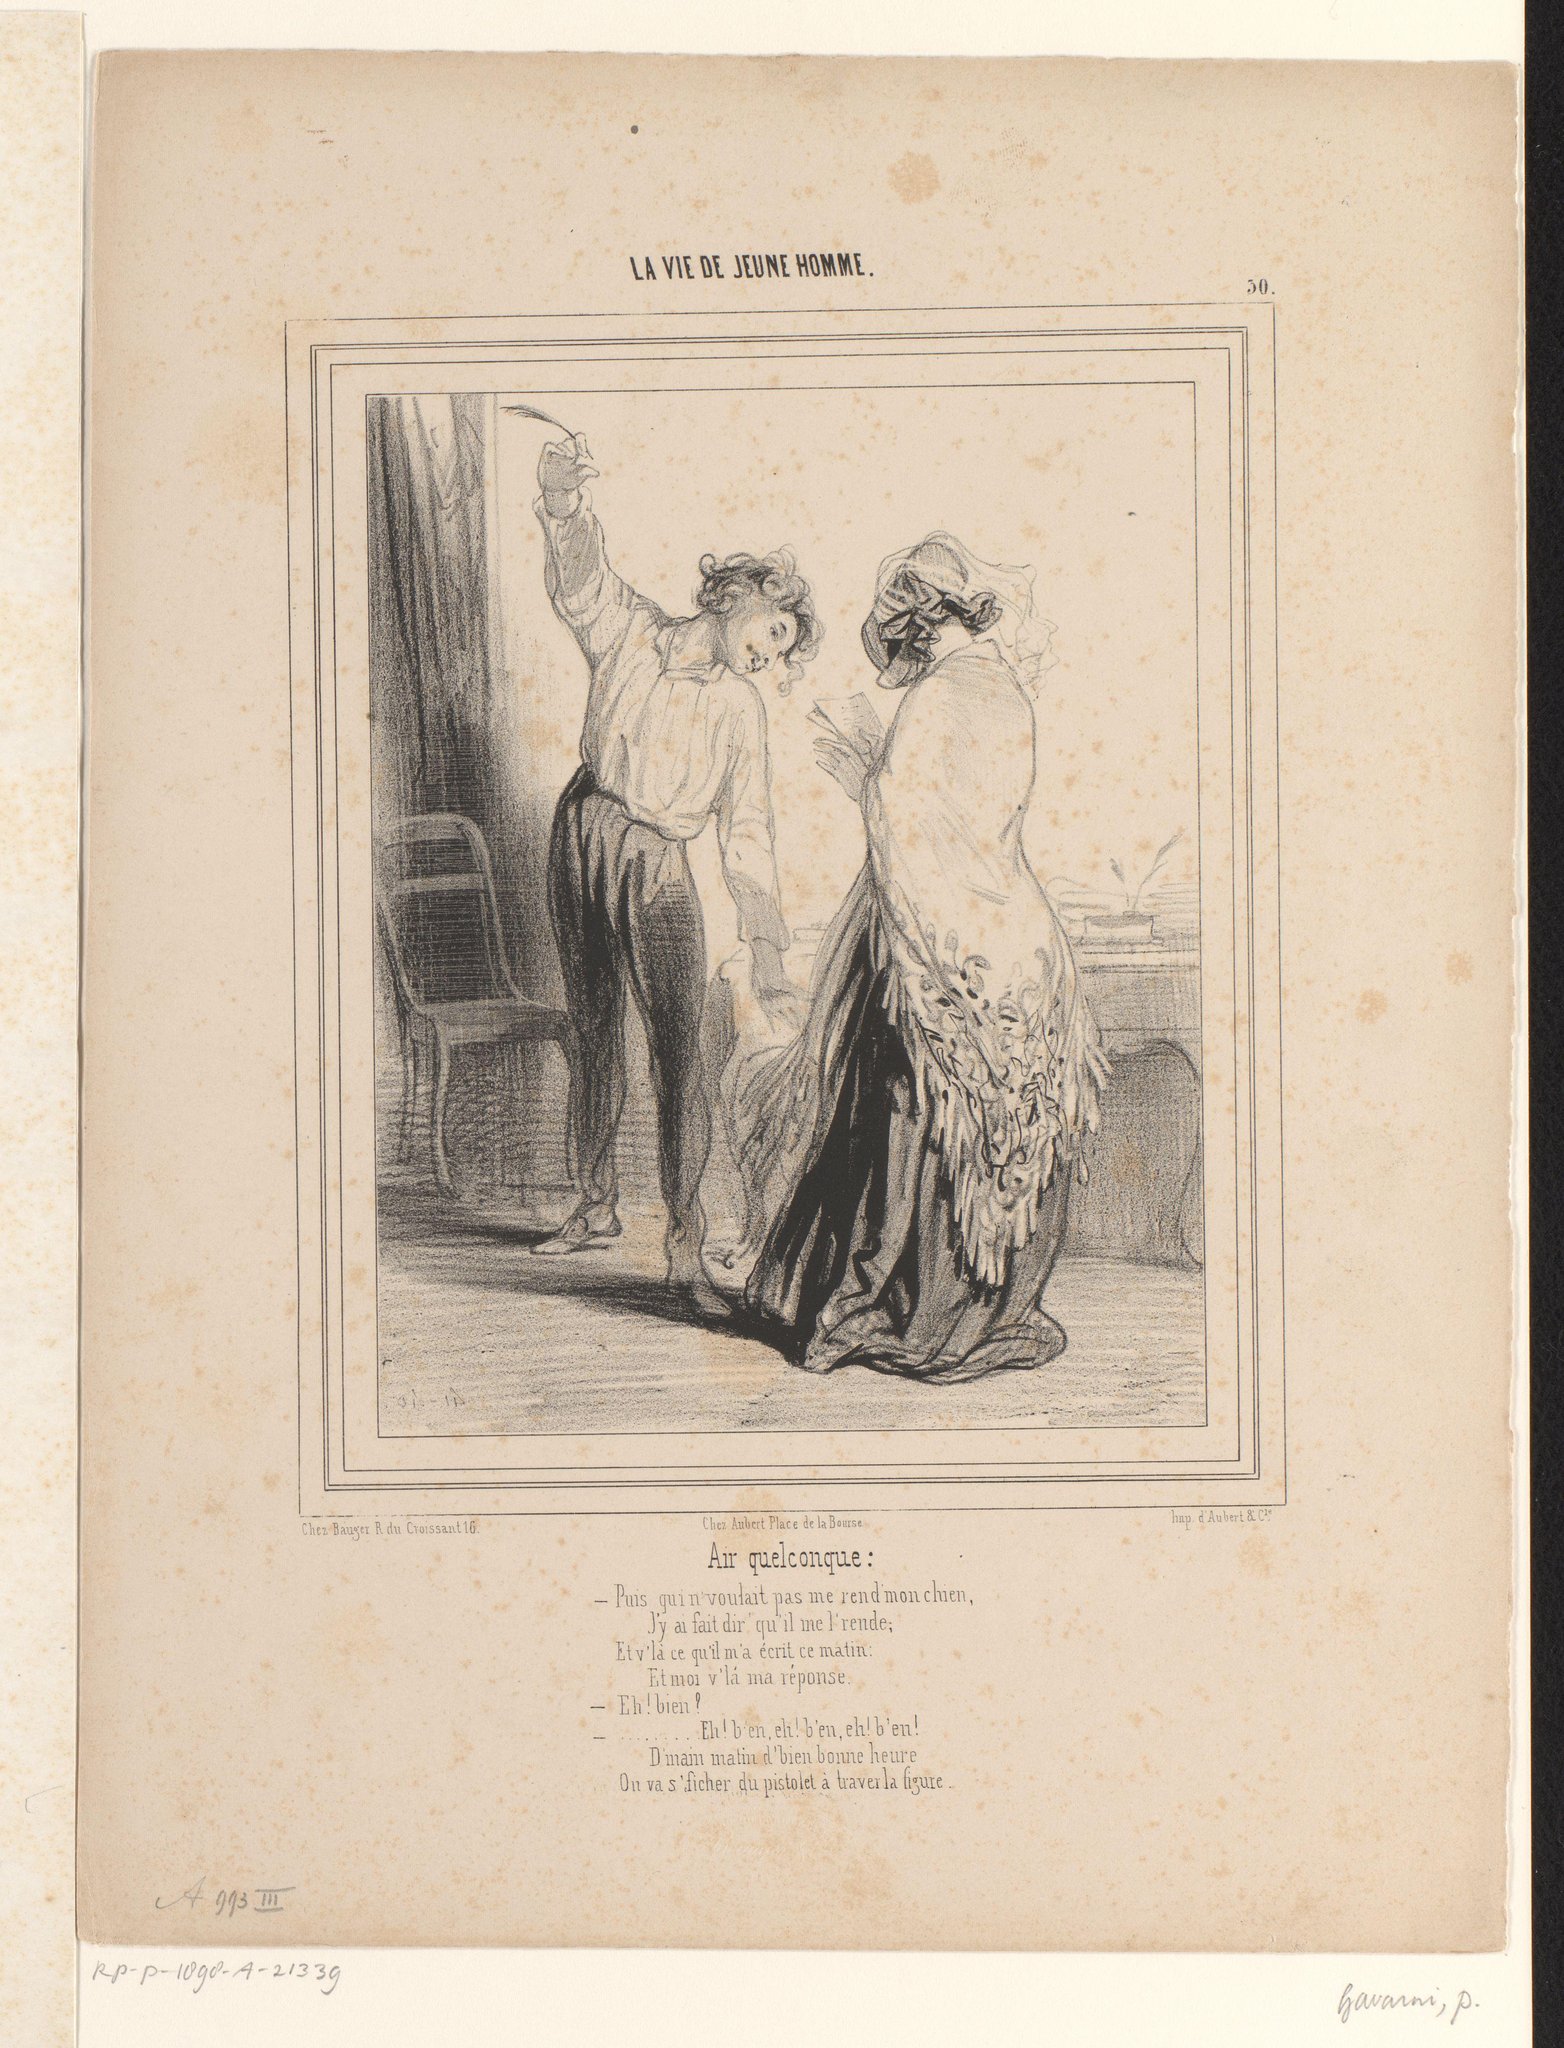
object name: print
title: Air quelconque: Puis qui n'voulait pas me rend'mon chien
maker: paul gavarni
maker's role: draughtsman, print maker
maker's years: 1804-1866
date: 1841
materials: paper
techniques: lithograph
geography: paris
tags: reading, man dancing alone, letter, envelope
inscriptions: collector's mark: Lugt 964, check stamp: Lugt 3855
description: Prent gebruikt voor: Le Charivari, 23 oktober 1841.